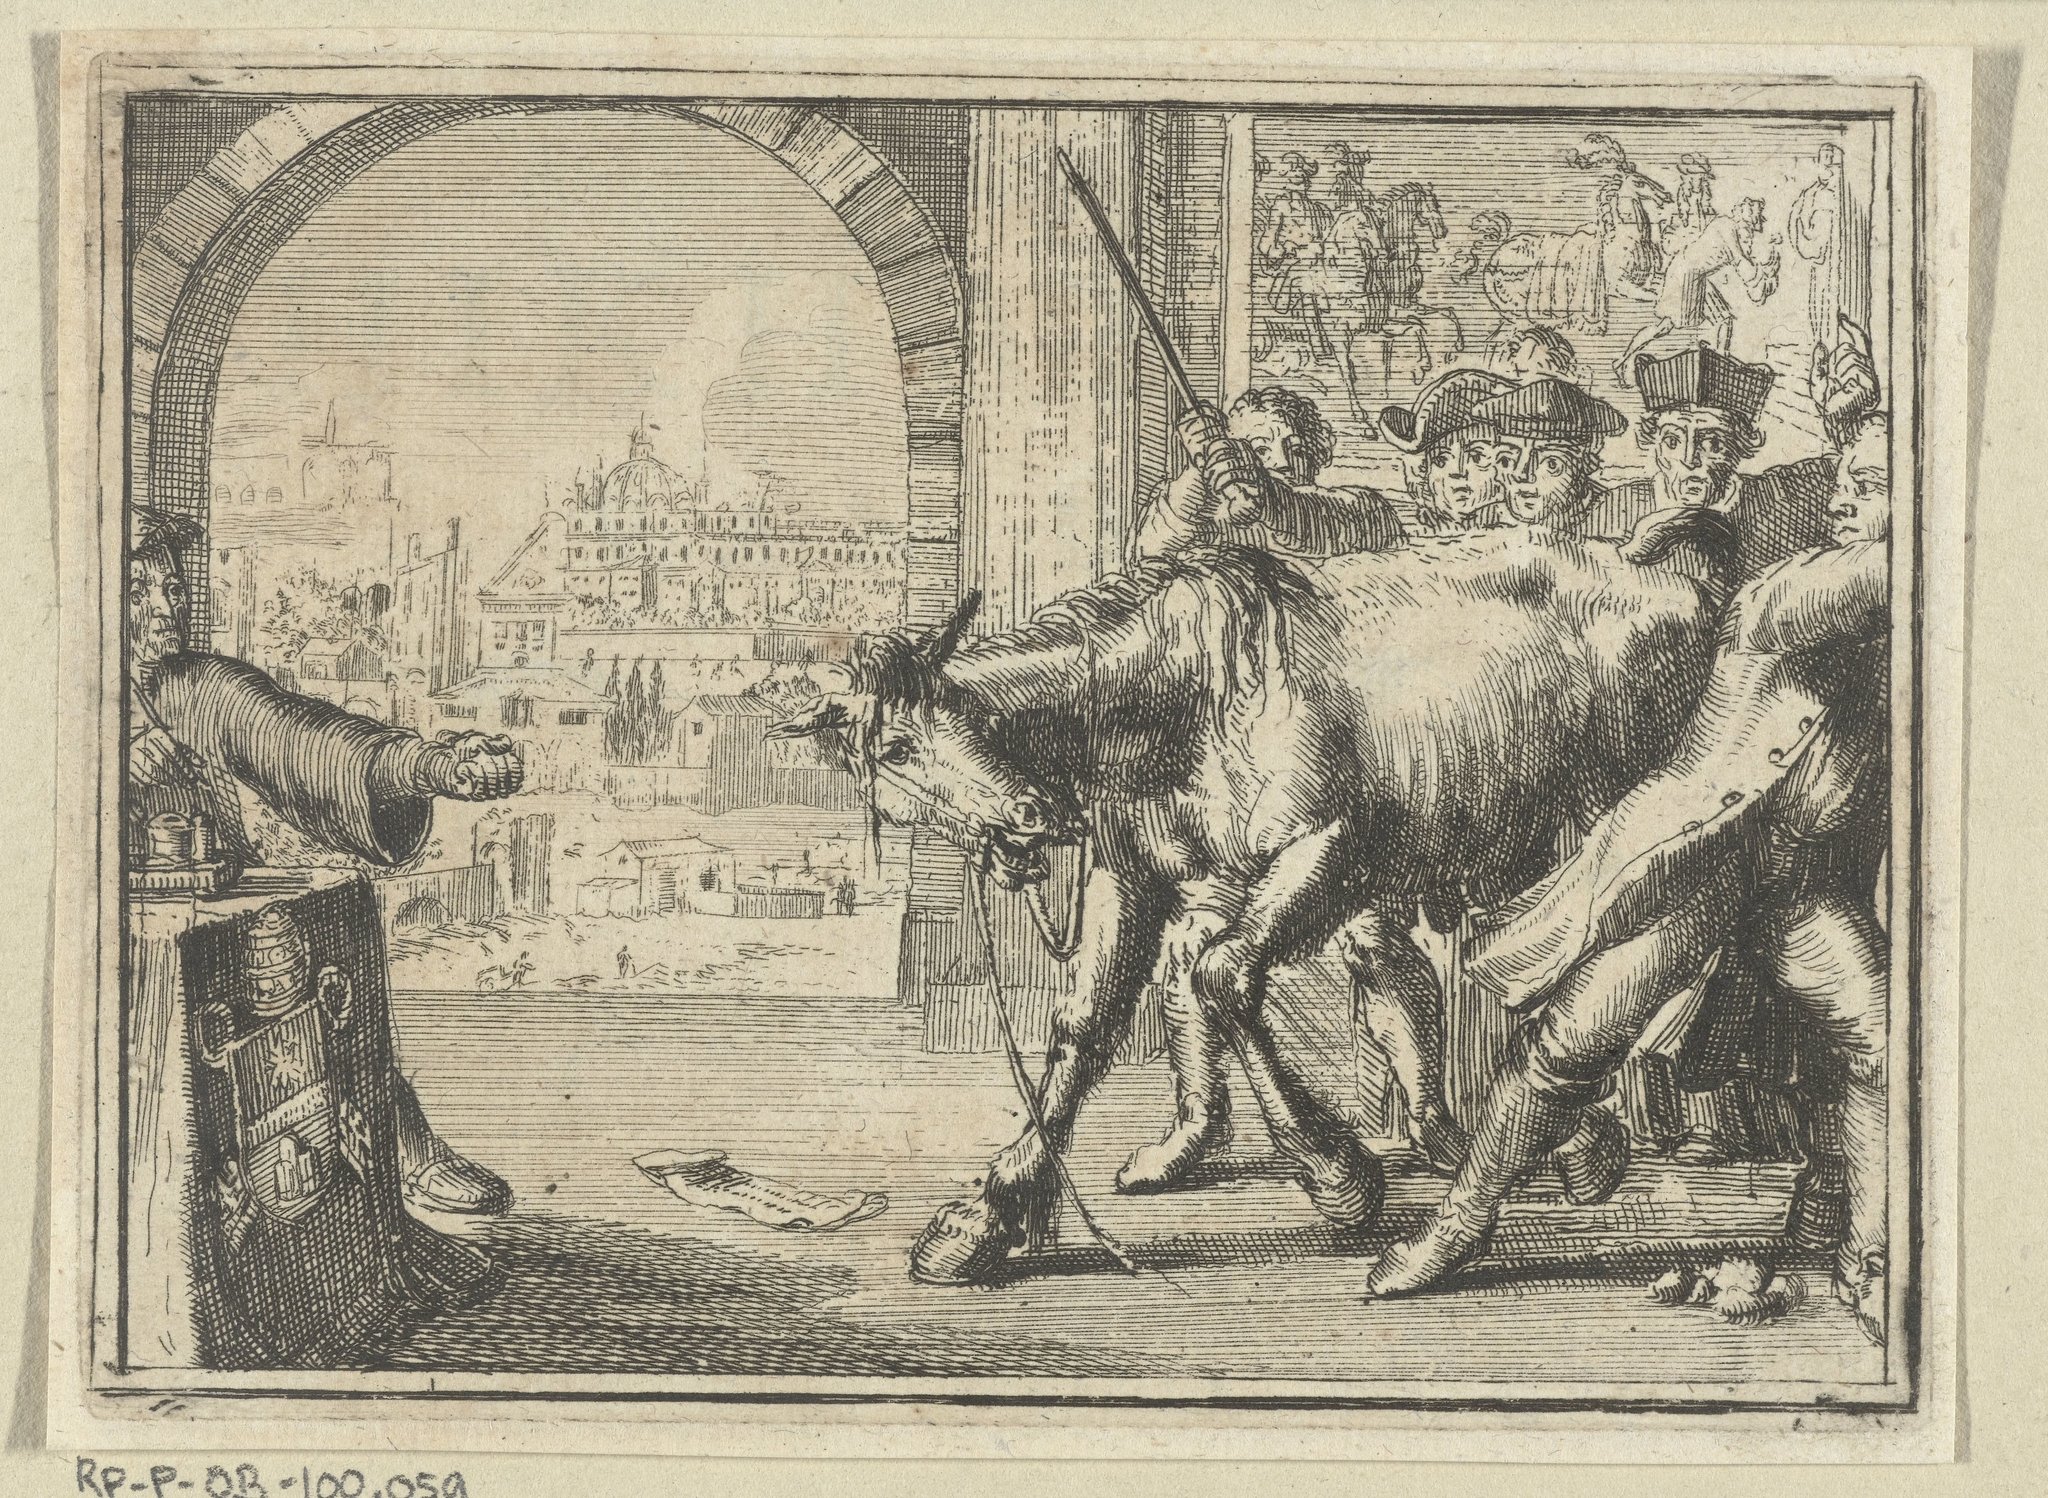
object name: print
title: Esopus in Europa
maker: romeyn de hooghe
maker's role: draughtsman, goldsmith, painter, print maker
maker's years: 1645-1708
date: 1701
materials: paper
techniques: etching, letterpress printing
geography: netherlands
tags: spaanse successieoorlog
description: Een paard tussen mensen in een gebouw, links een boog met uitzicht op een stad (Rome?). Titel staat op apart tekstblad.